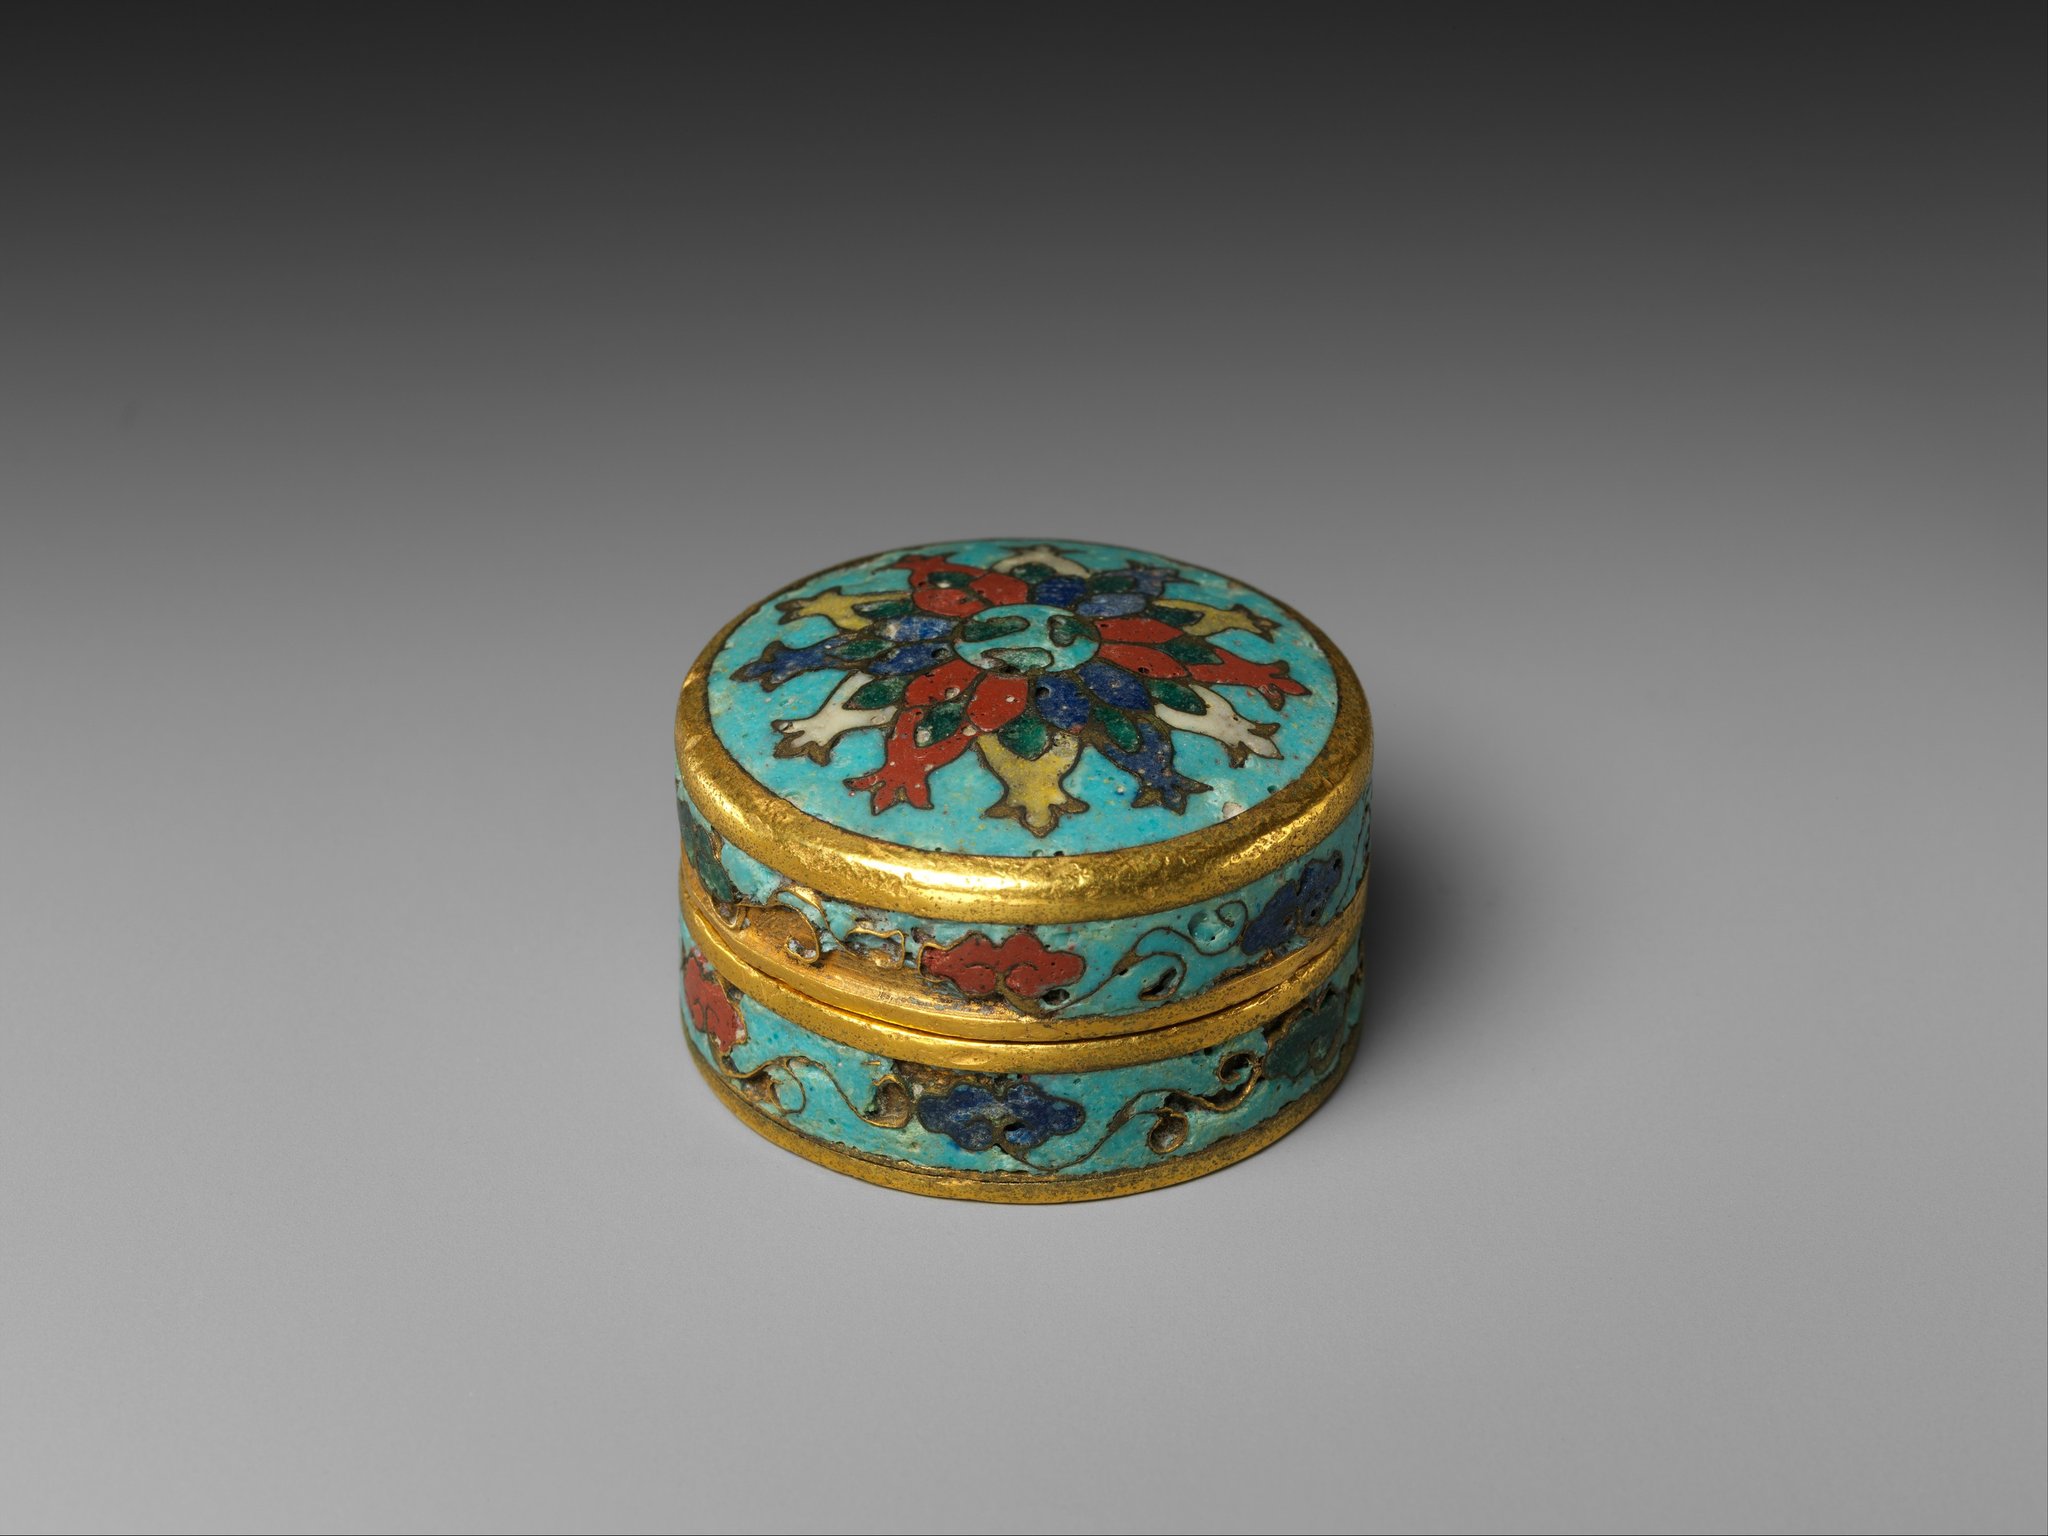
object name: box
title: Small box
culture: chinese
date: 1401-1500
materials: gilt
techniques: enamel